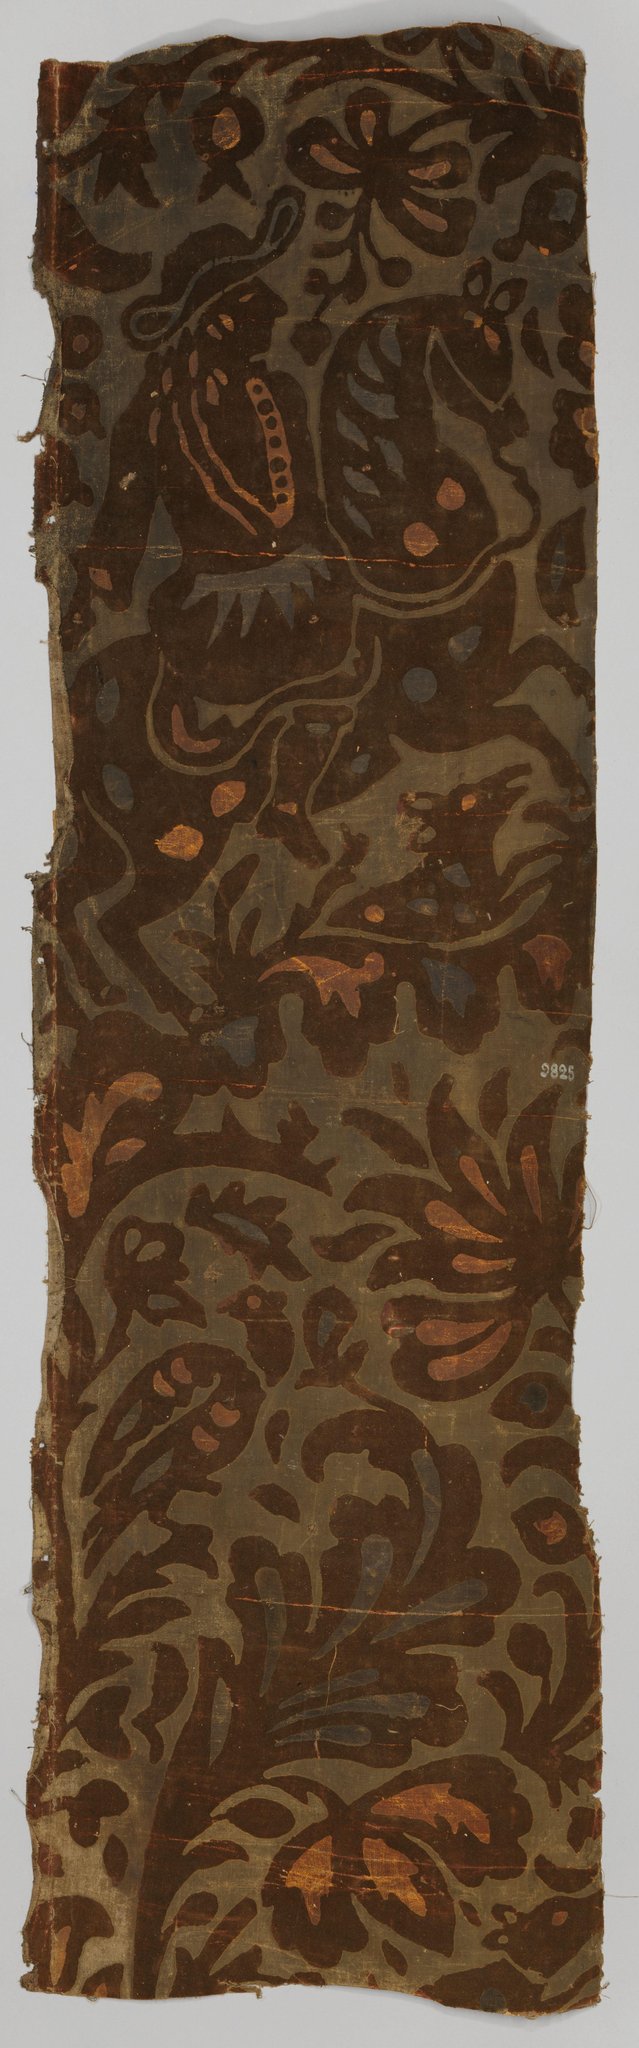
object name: flock paper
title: Baan veloutébehang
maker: Anonymous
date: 1700-1750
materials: linen, wool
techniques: velvet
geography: northern netherlands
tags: cologne, amsterdam, joost van den vondel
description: Baan veloutébehang, dat op een gebroken wit fond een patroon in bruin velouté met rode en groene vullingen vertoont. Tussen bloem- en bladranken zijn jagers te paard, herten en honden te zien. Zie tevens: BK-NM-9825-a/b.